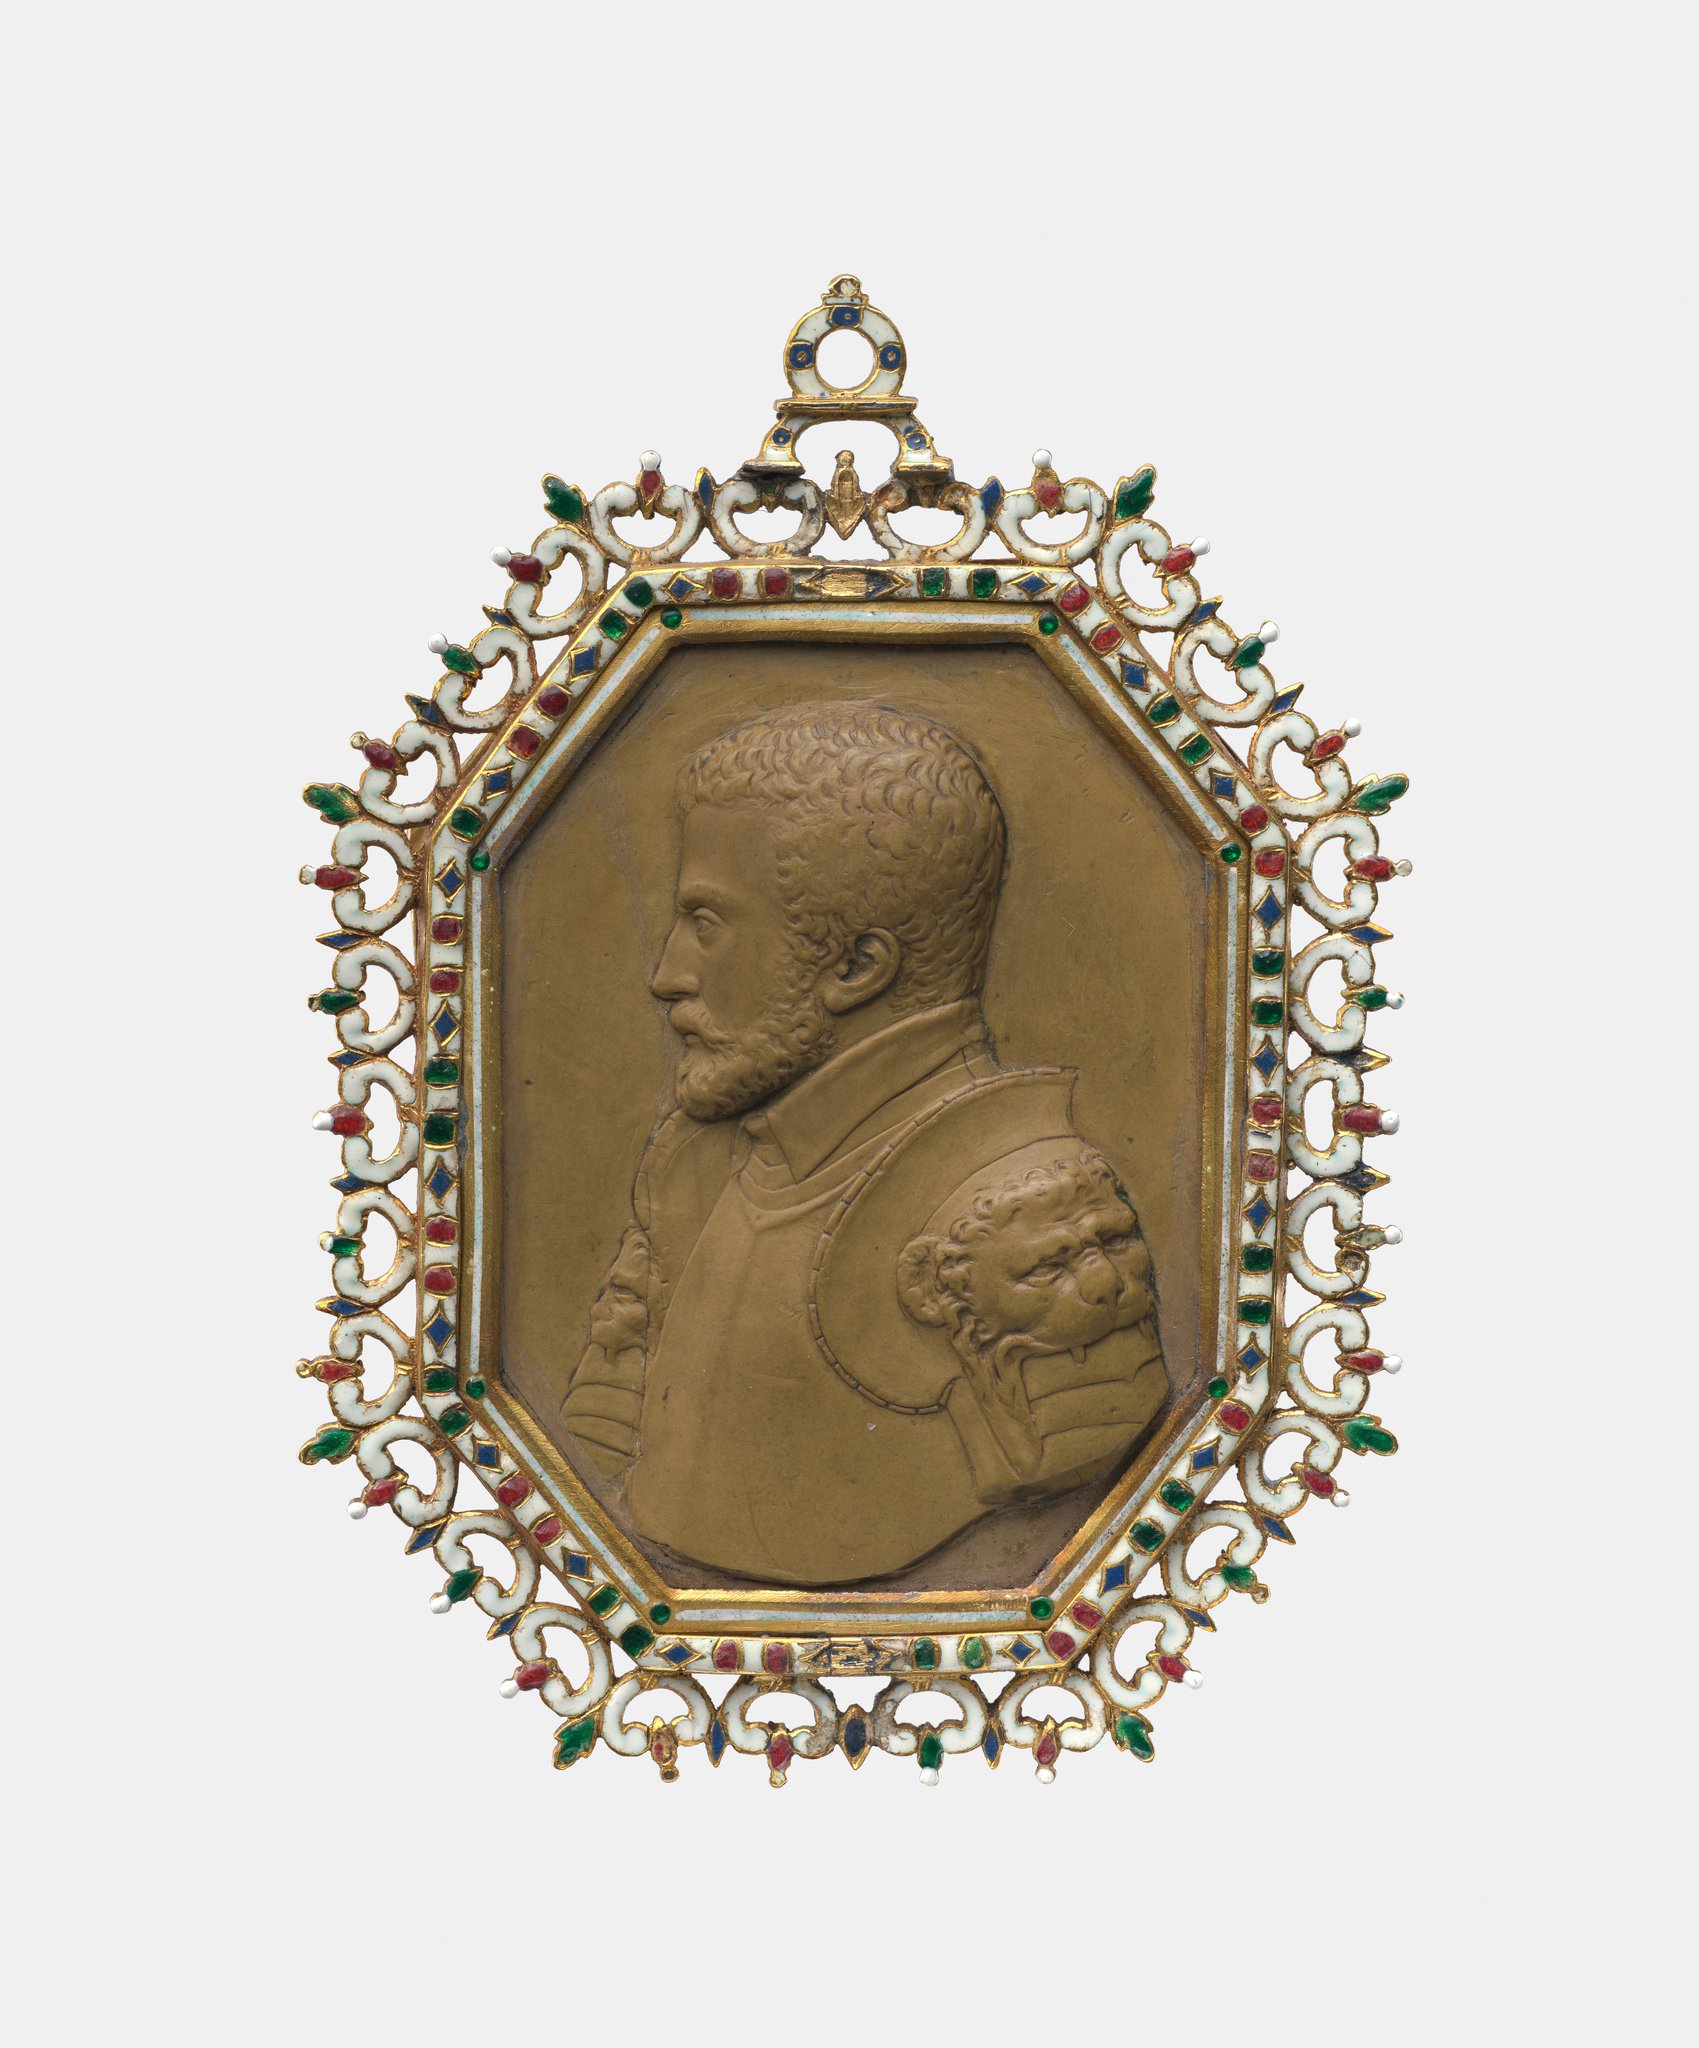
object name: bijou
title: Unknown Nobleman, possibly Cosimo I de' Medici, 1519-74; married 1539 to Eleonora de Toledo; Duke of Florence 1537-69, Grand Duke of Tuscany 1569-74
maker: Anonymous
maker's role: artist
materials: enamel, gold